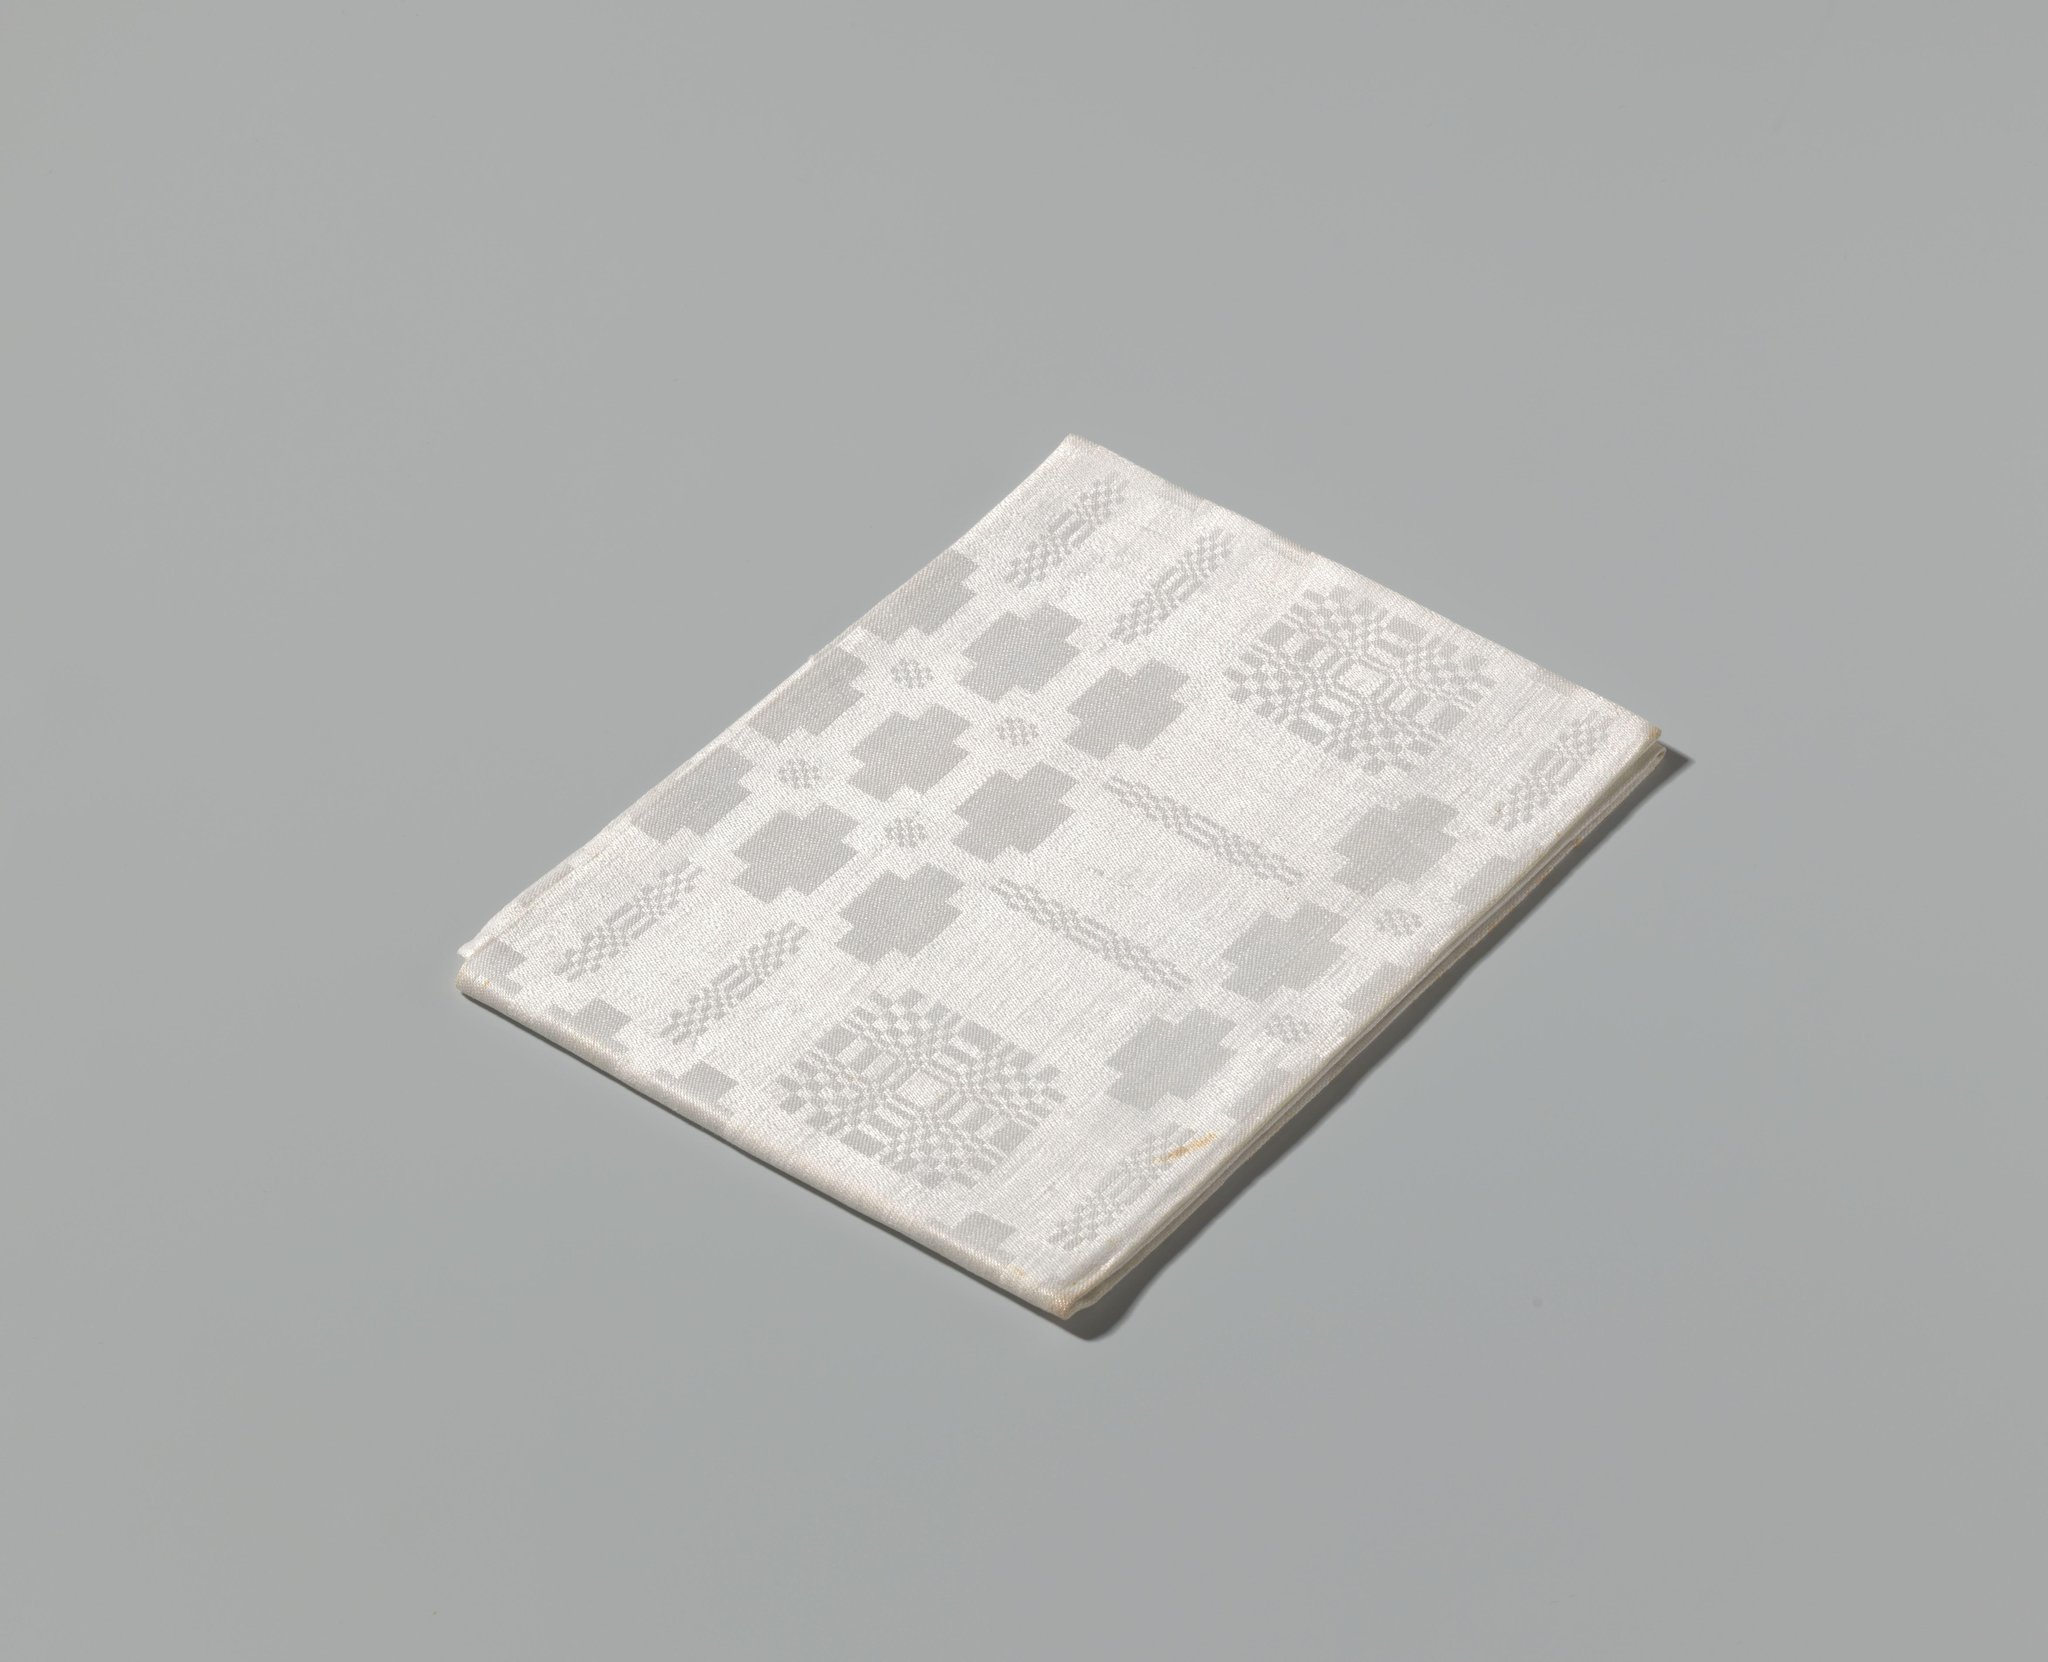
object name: napkin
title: Servet met pellenpatroon. Merk: kroon G 30.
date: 1725-1775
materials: linen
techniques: peeled fabric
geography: northern netherlands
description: wit linnen servet met pellen patroon, merk kroon G 30